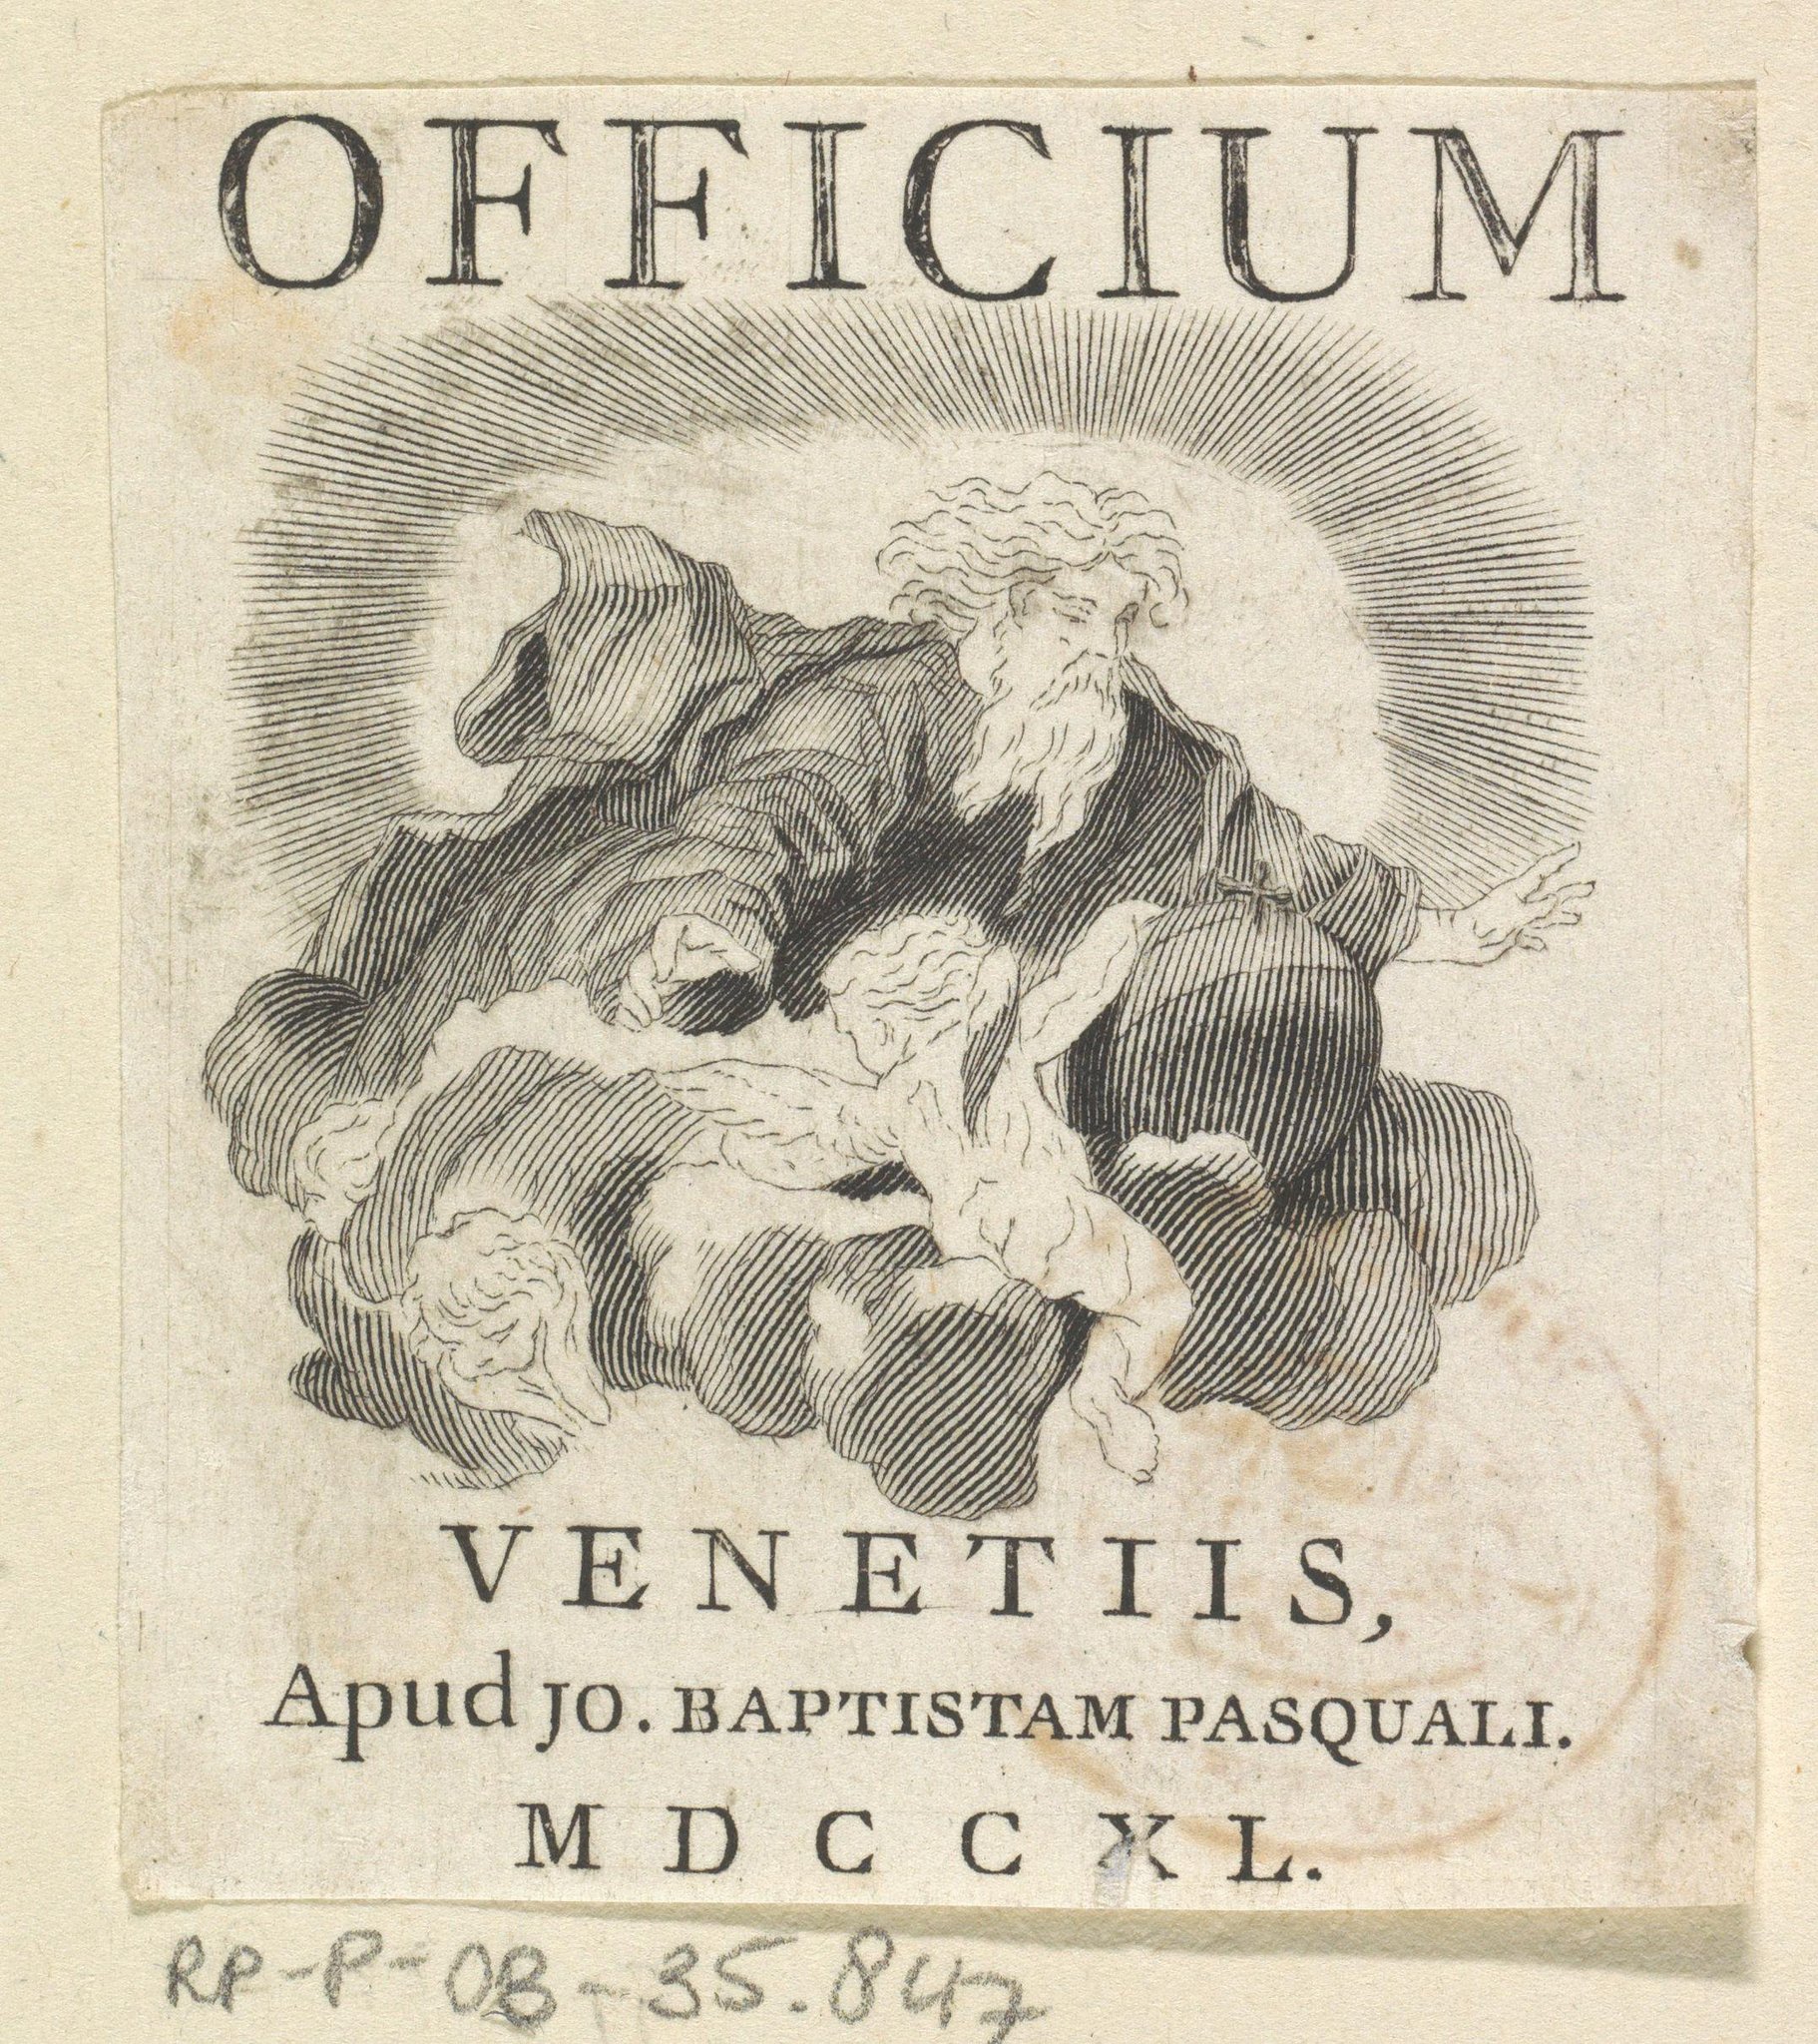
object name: titelprent, frontispice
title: Beatae Mariae virginis officium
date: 1740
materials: paper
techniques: engraving, etching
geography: italy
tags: cherubs, i.e. children's heads with wings, god the father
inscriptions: collector's mark: Lugt 240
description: Titelprent bij een reeks van 16 prenten.